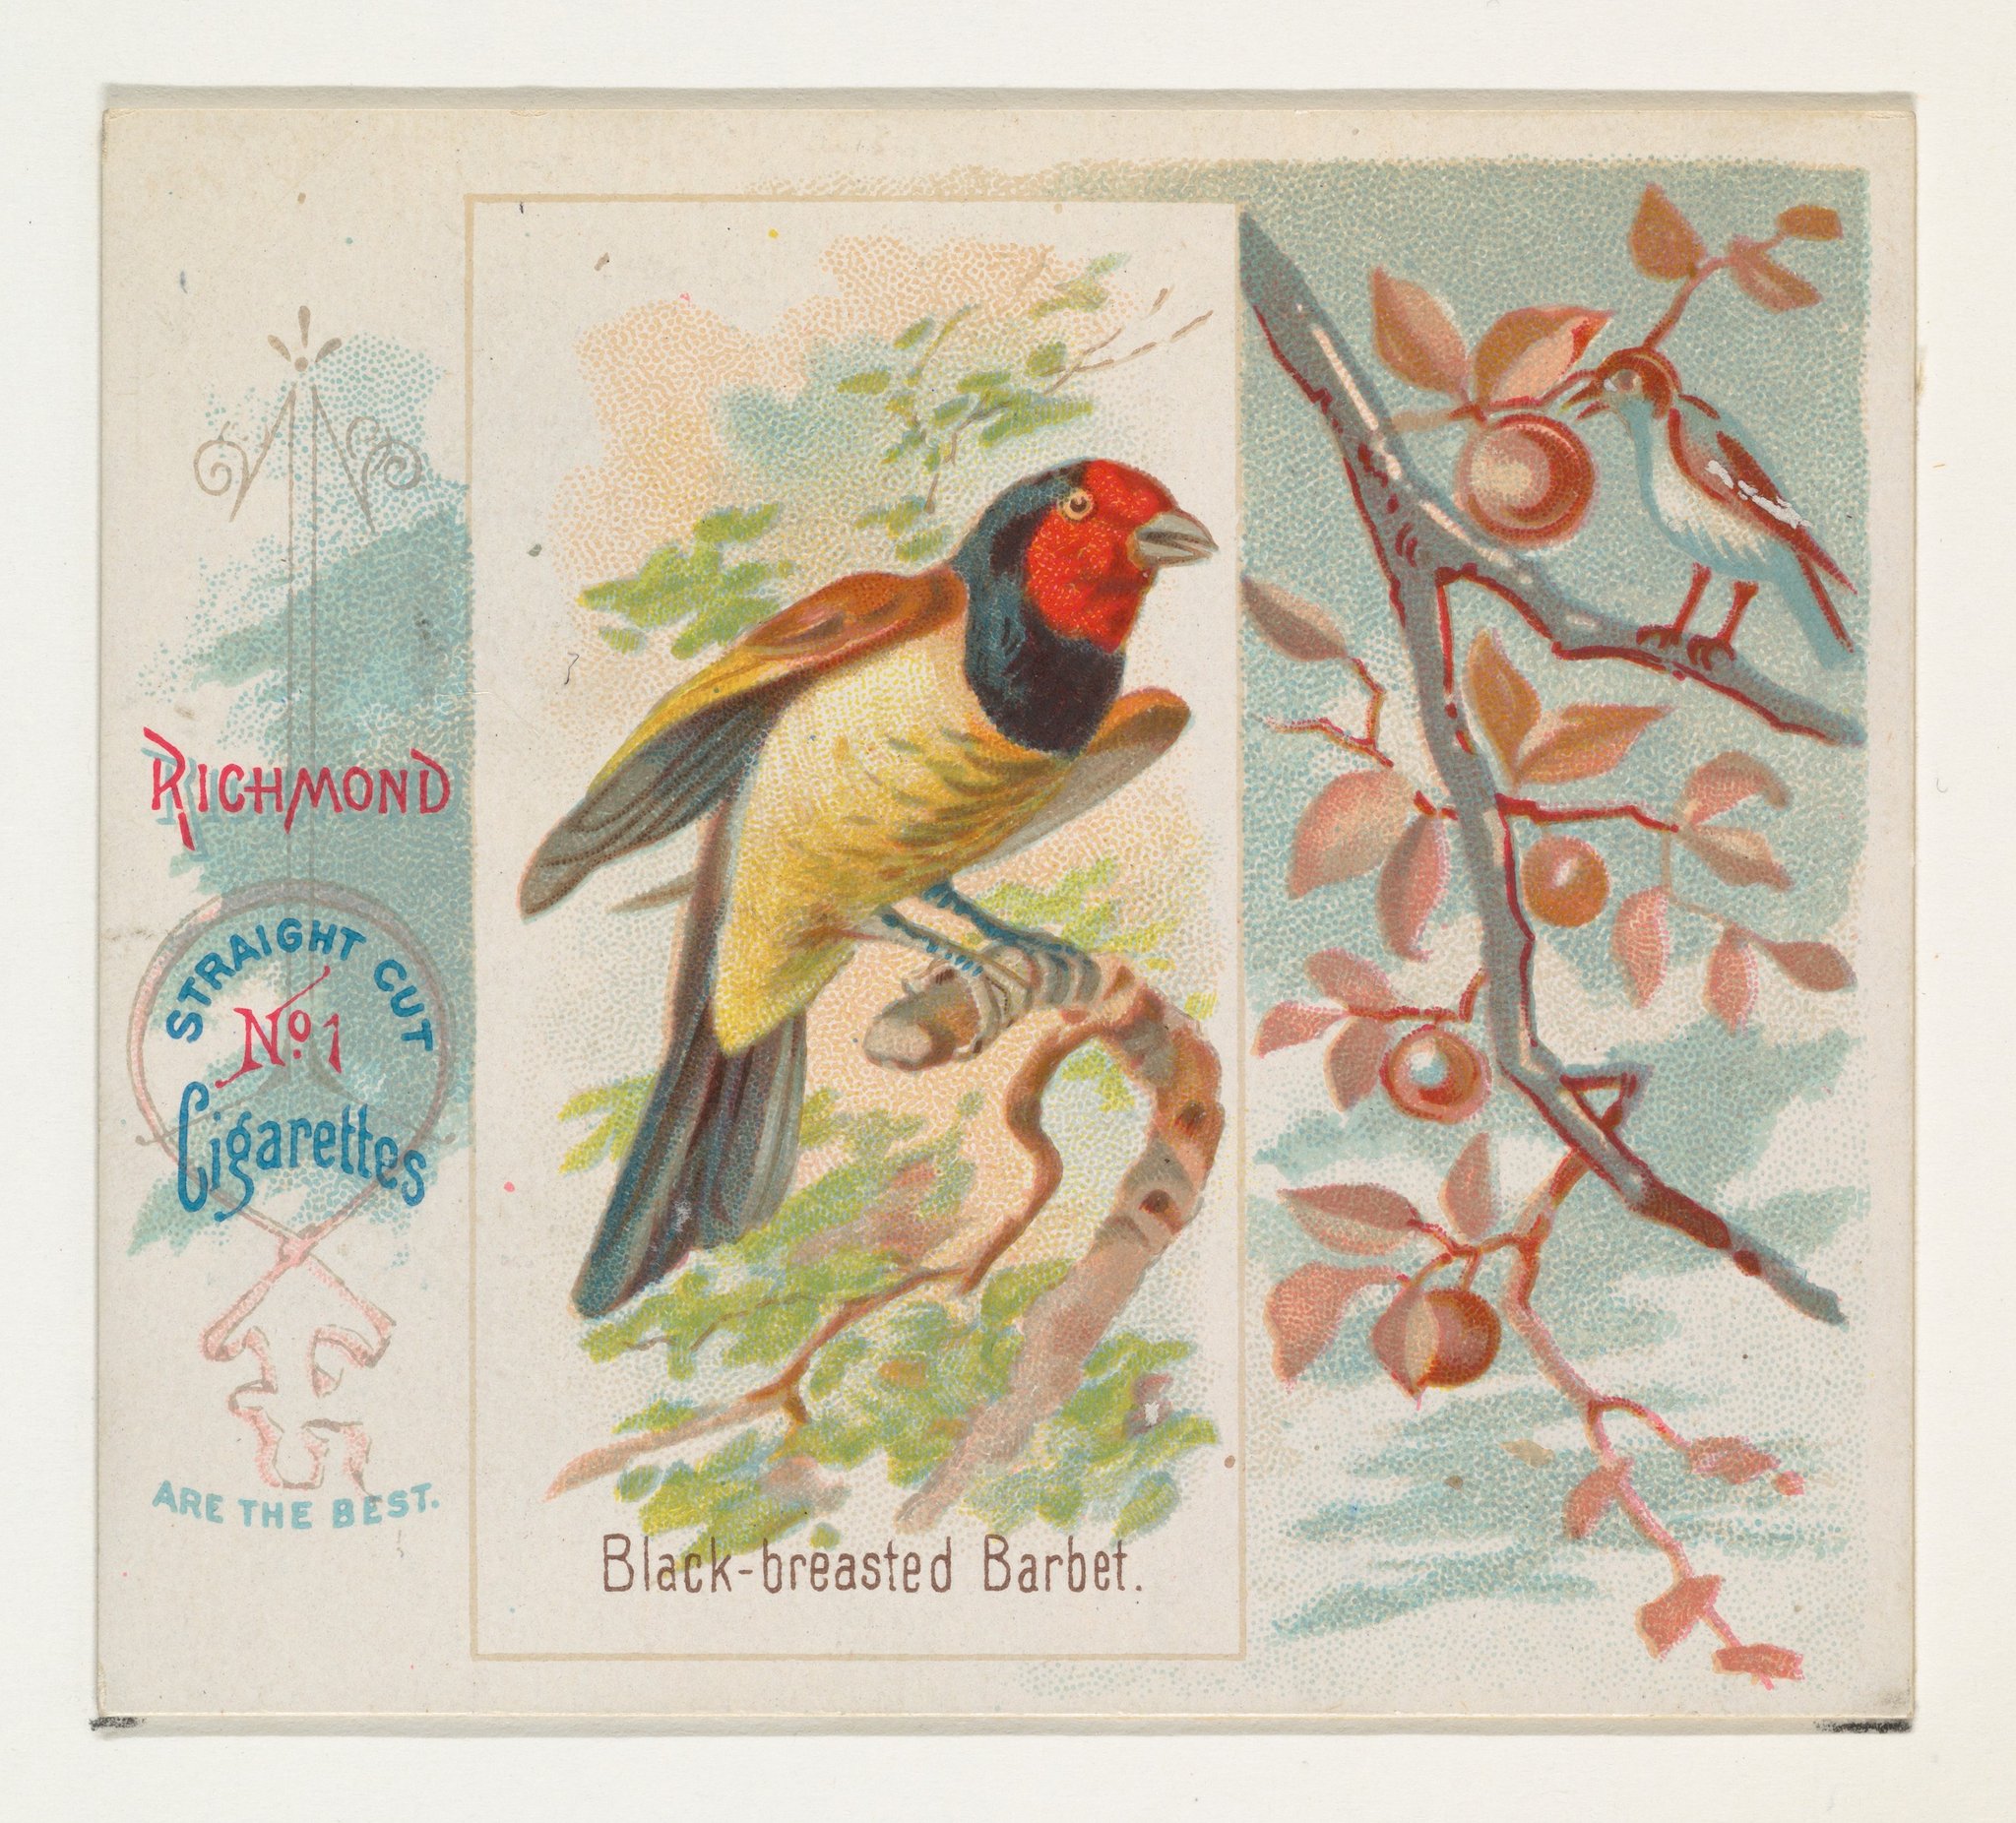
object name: print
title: Black-breasted Barbet, from the Song Birds of the World series (N42) for Allen & Ginter Cigarettes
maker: allen & ginter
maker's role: publisher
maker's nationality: american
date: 1890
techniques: color lithograph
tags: birds